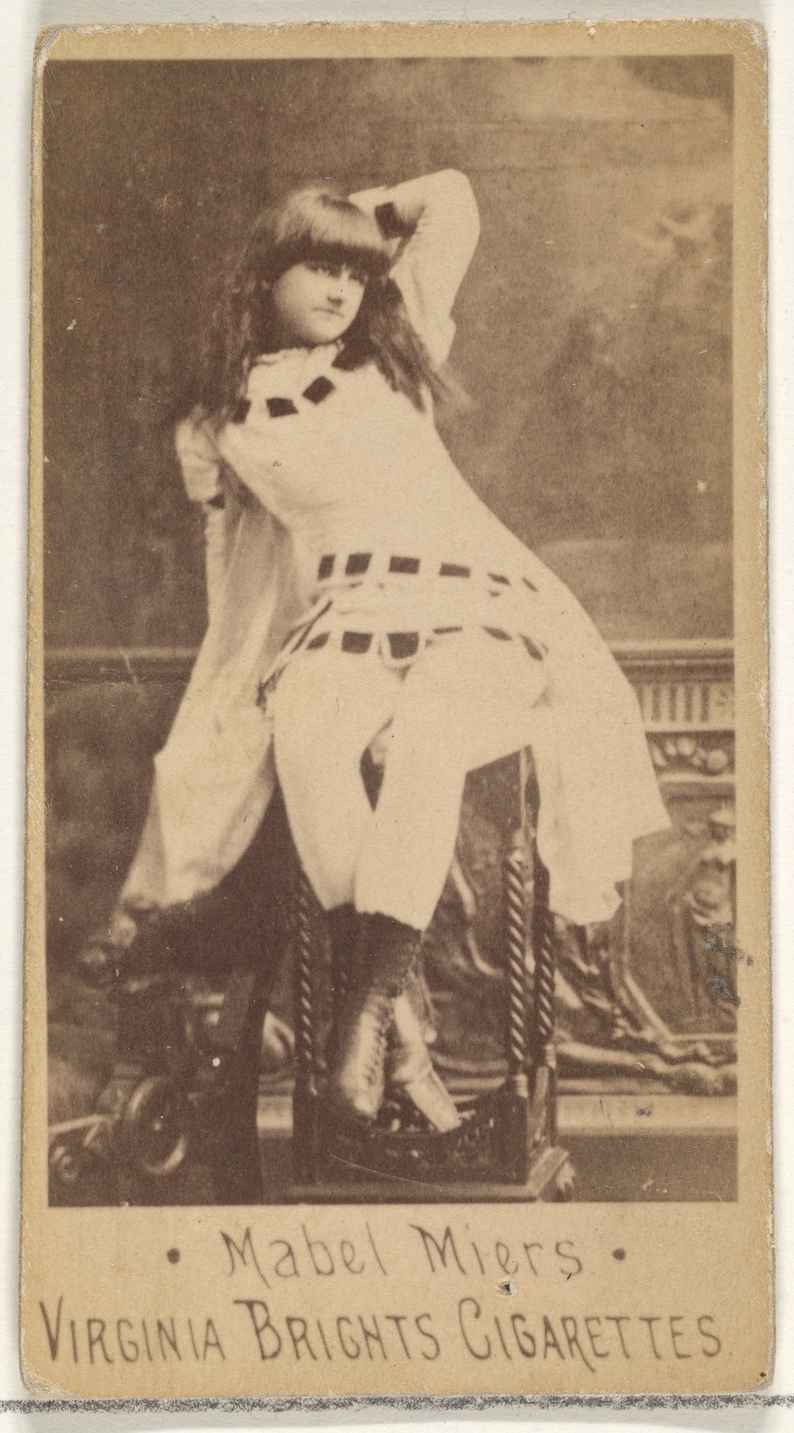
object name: photograph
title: Mabel Miers, from the Actors and Actresses series (N45, Type 1) for Virginia Brights Cigarettes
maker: allen & ginter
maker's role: publisher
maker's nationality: american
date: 1888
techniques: albumen silver print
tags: girls,portraits,actresses